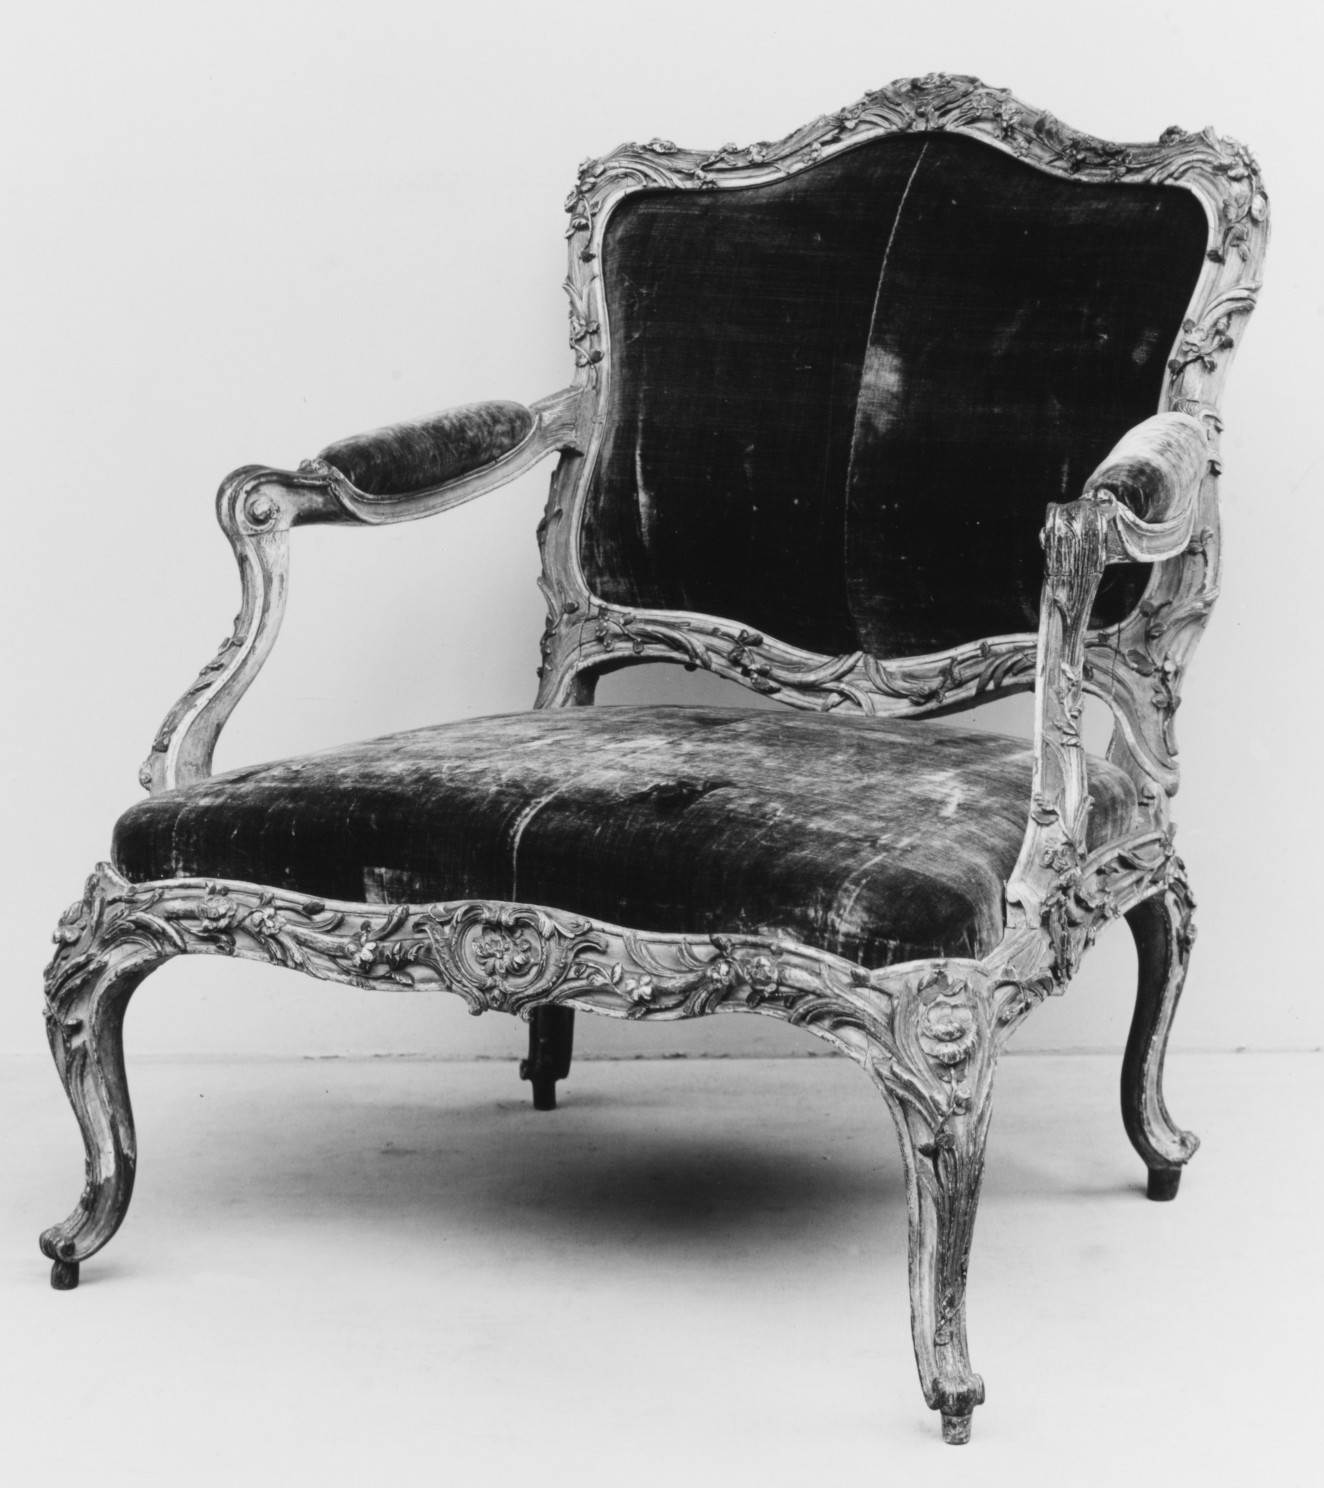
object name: armchair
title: Armchair (fauteuil)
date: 1726-1750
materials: silk, wood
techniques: carving, gilding, painting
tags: flowers